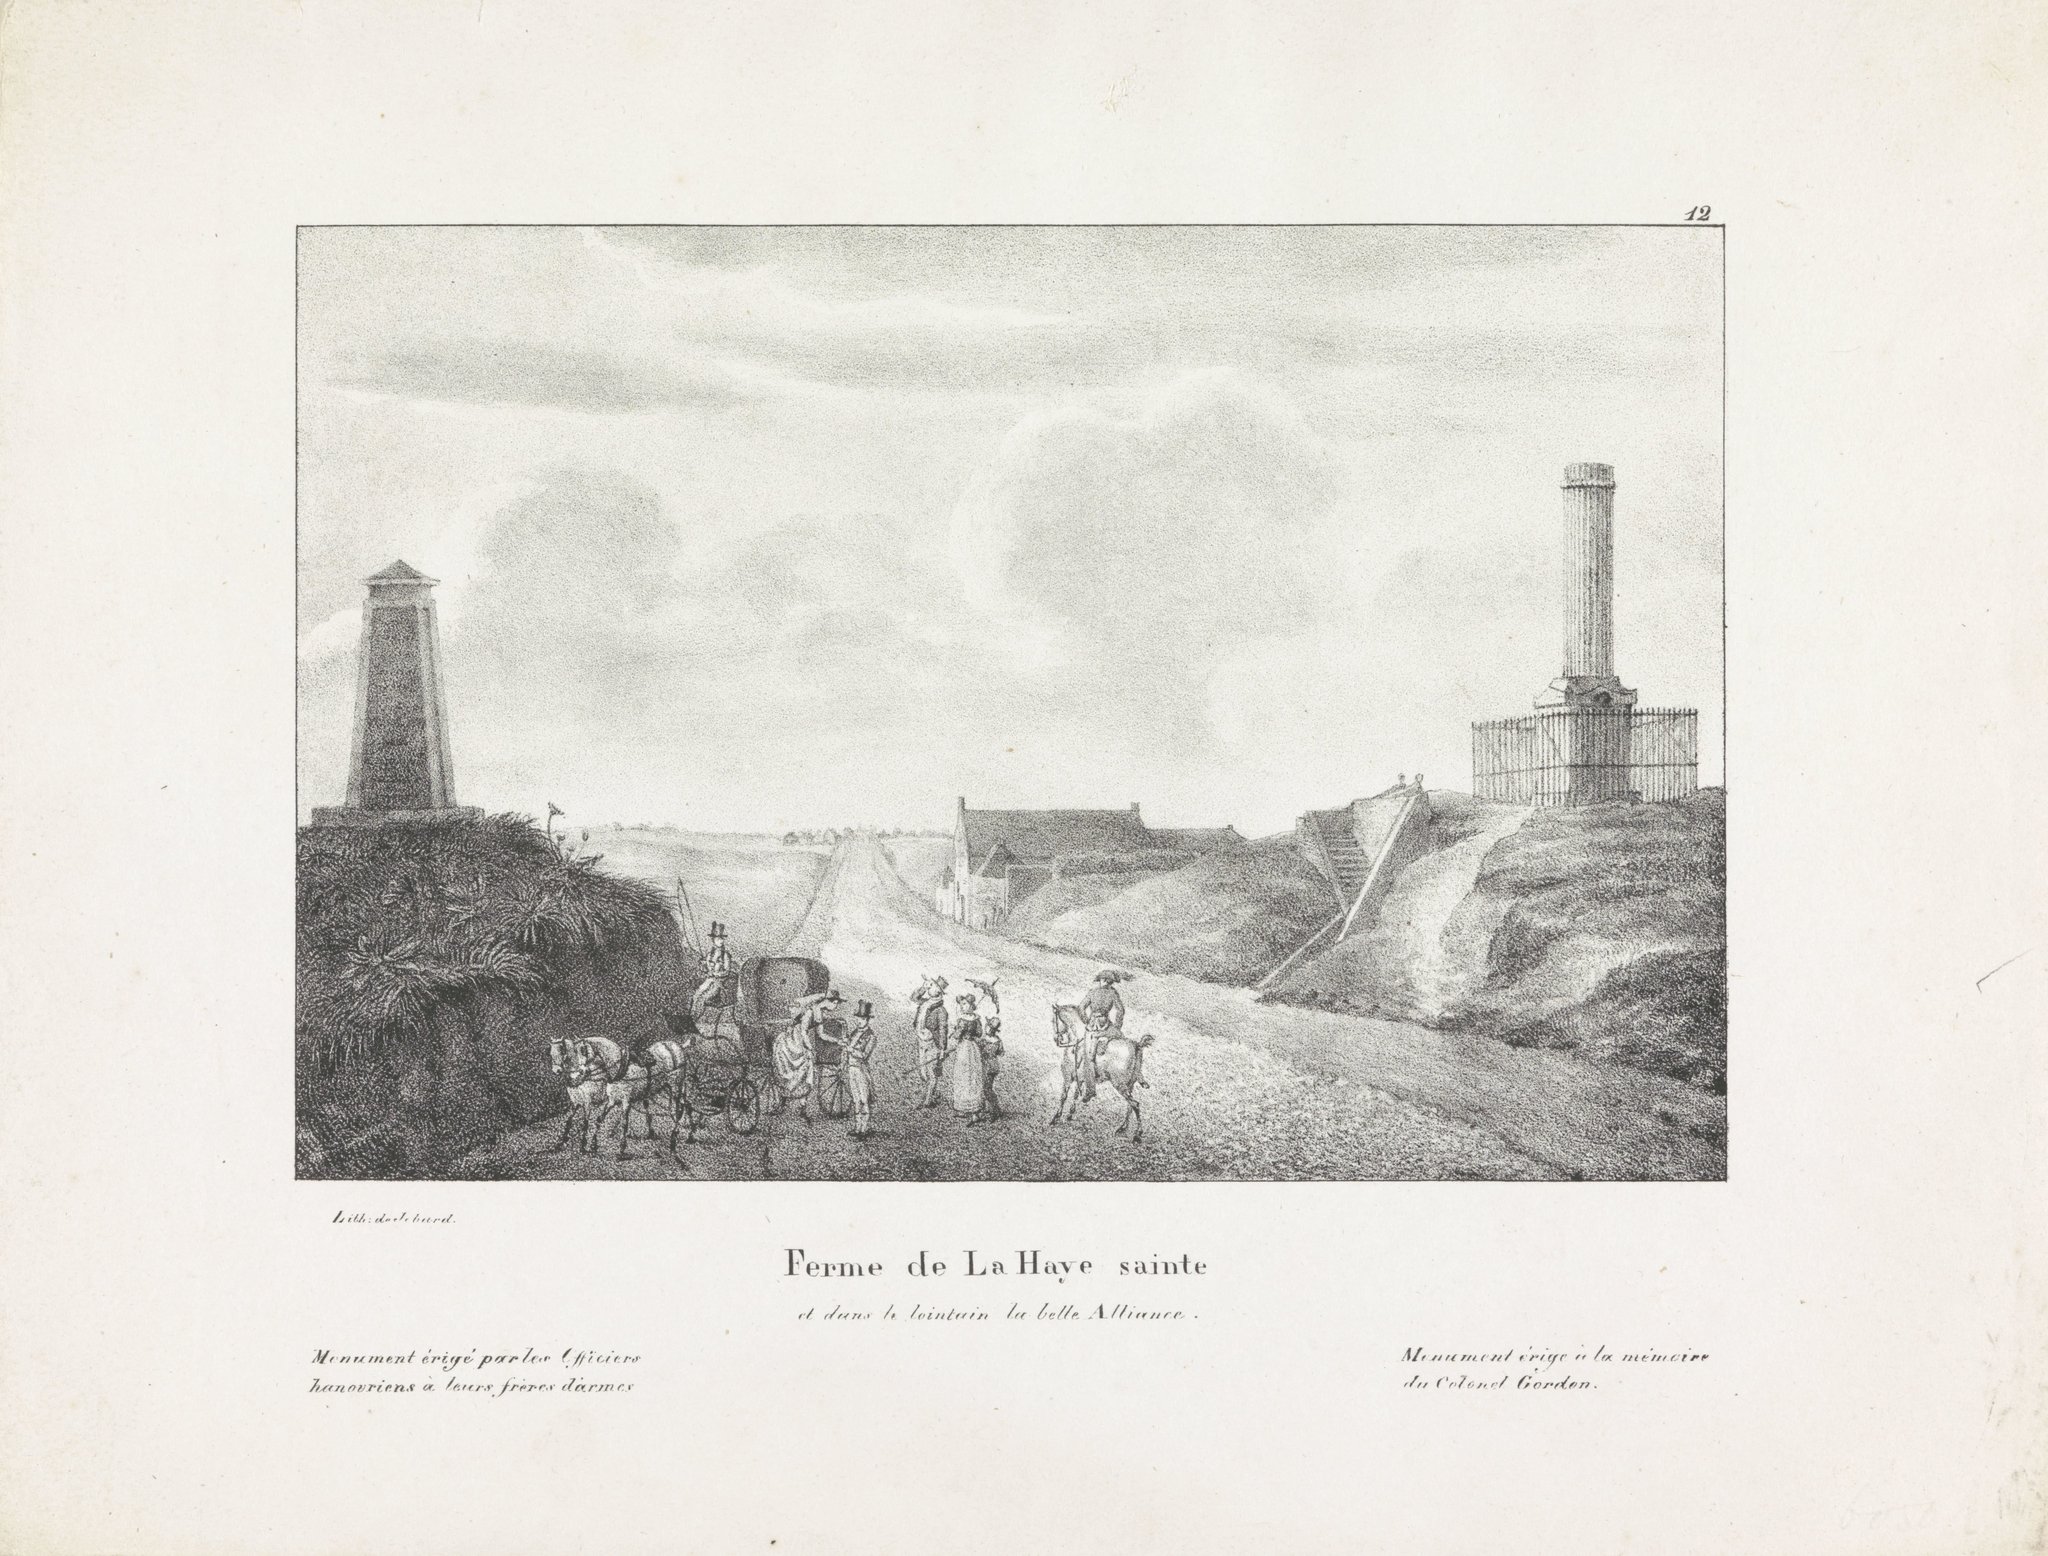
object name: print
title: Hoeve La Haye-Sainte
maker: jean baptiste ambroise marcellin jobard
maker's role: print maker, publisher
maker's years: 1792-1861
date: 1820-1850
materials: paper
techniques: lithograph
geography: brussels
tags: landscape with monument, waterloo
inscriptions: collector's mark: Lugt 2228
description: Gezicht op een weg langs het slagveld met de hoeve La Haye-Sainte en in de verte la Belle Alliance. Op de voorgropnd is op de weg een rijtuig gestopt zodat de passagiers de monumenten kunnen bezichtigen. Links het monument voor de gevallen Hannoveraanse militairen, rechts het monument voor kolonel Alexander Gordon. Rechtsboven genummerd: 12.